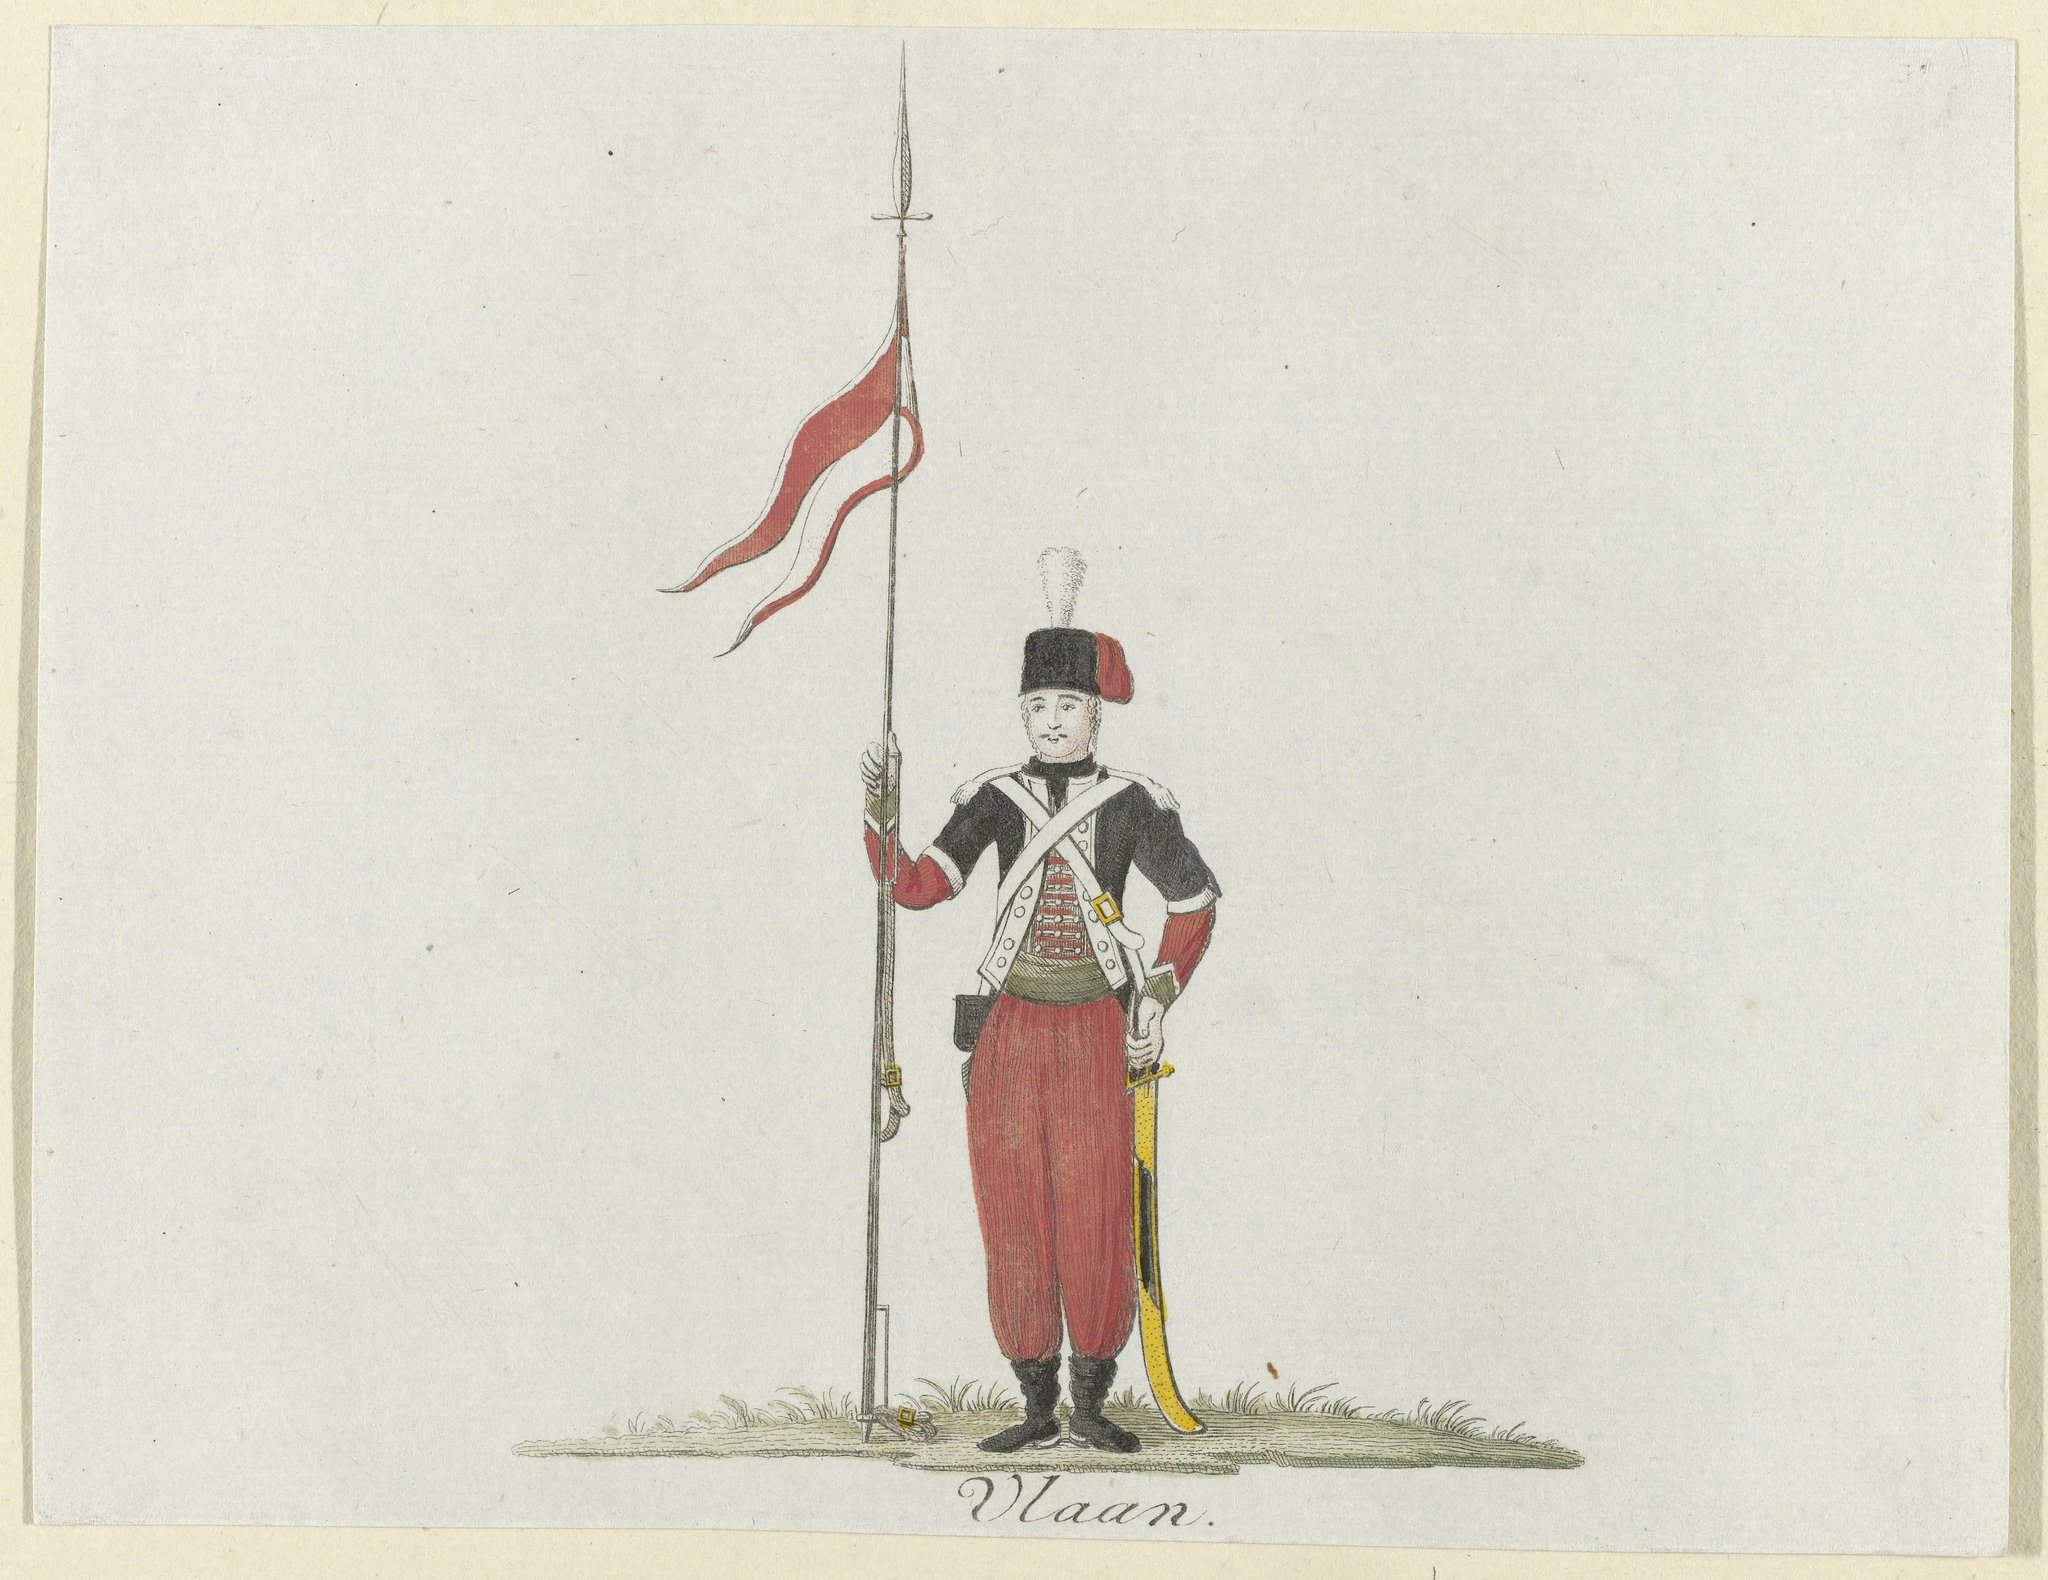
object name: print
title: Ulaan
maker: Anonymous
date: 1785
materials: paper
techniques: etching, hand coloring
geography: northern netherlands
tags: rijngraaf van salm frederik iii, (military) uniforms (+ infantry), patriots (1780-1795)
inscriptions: collector's mark: Lugt 2228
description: Staande Ulaan in uniform met vaandel. Onderdeel van de prentserie van uniformen van het legioen van Frederik III Rijngraaf van Salm, in dienst van Republiek in 1785.